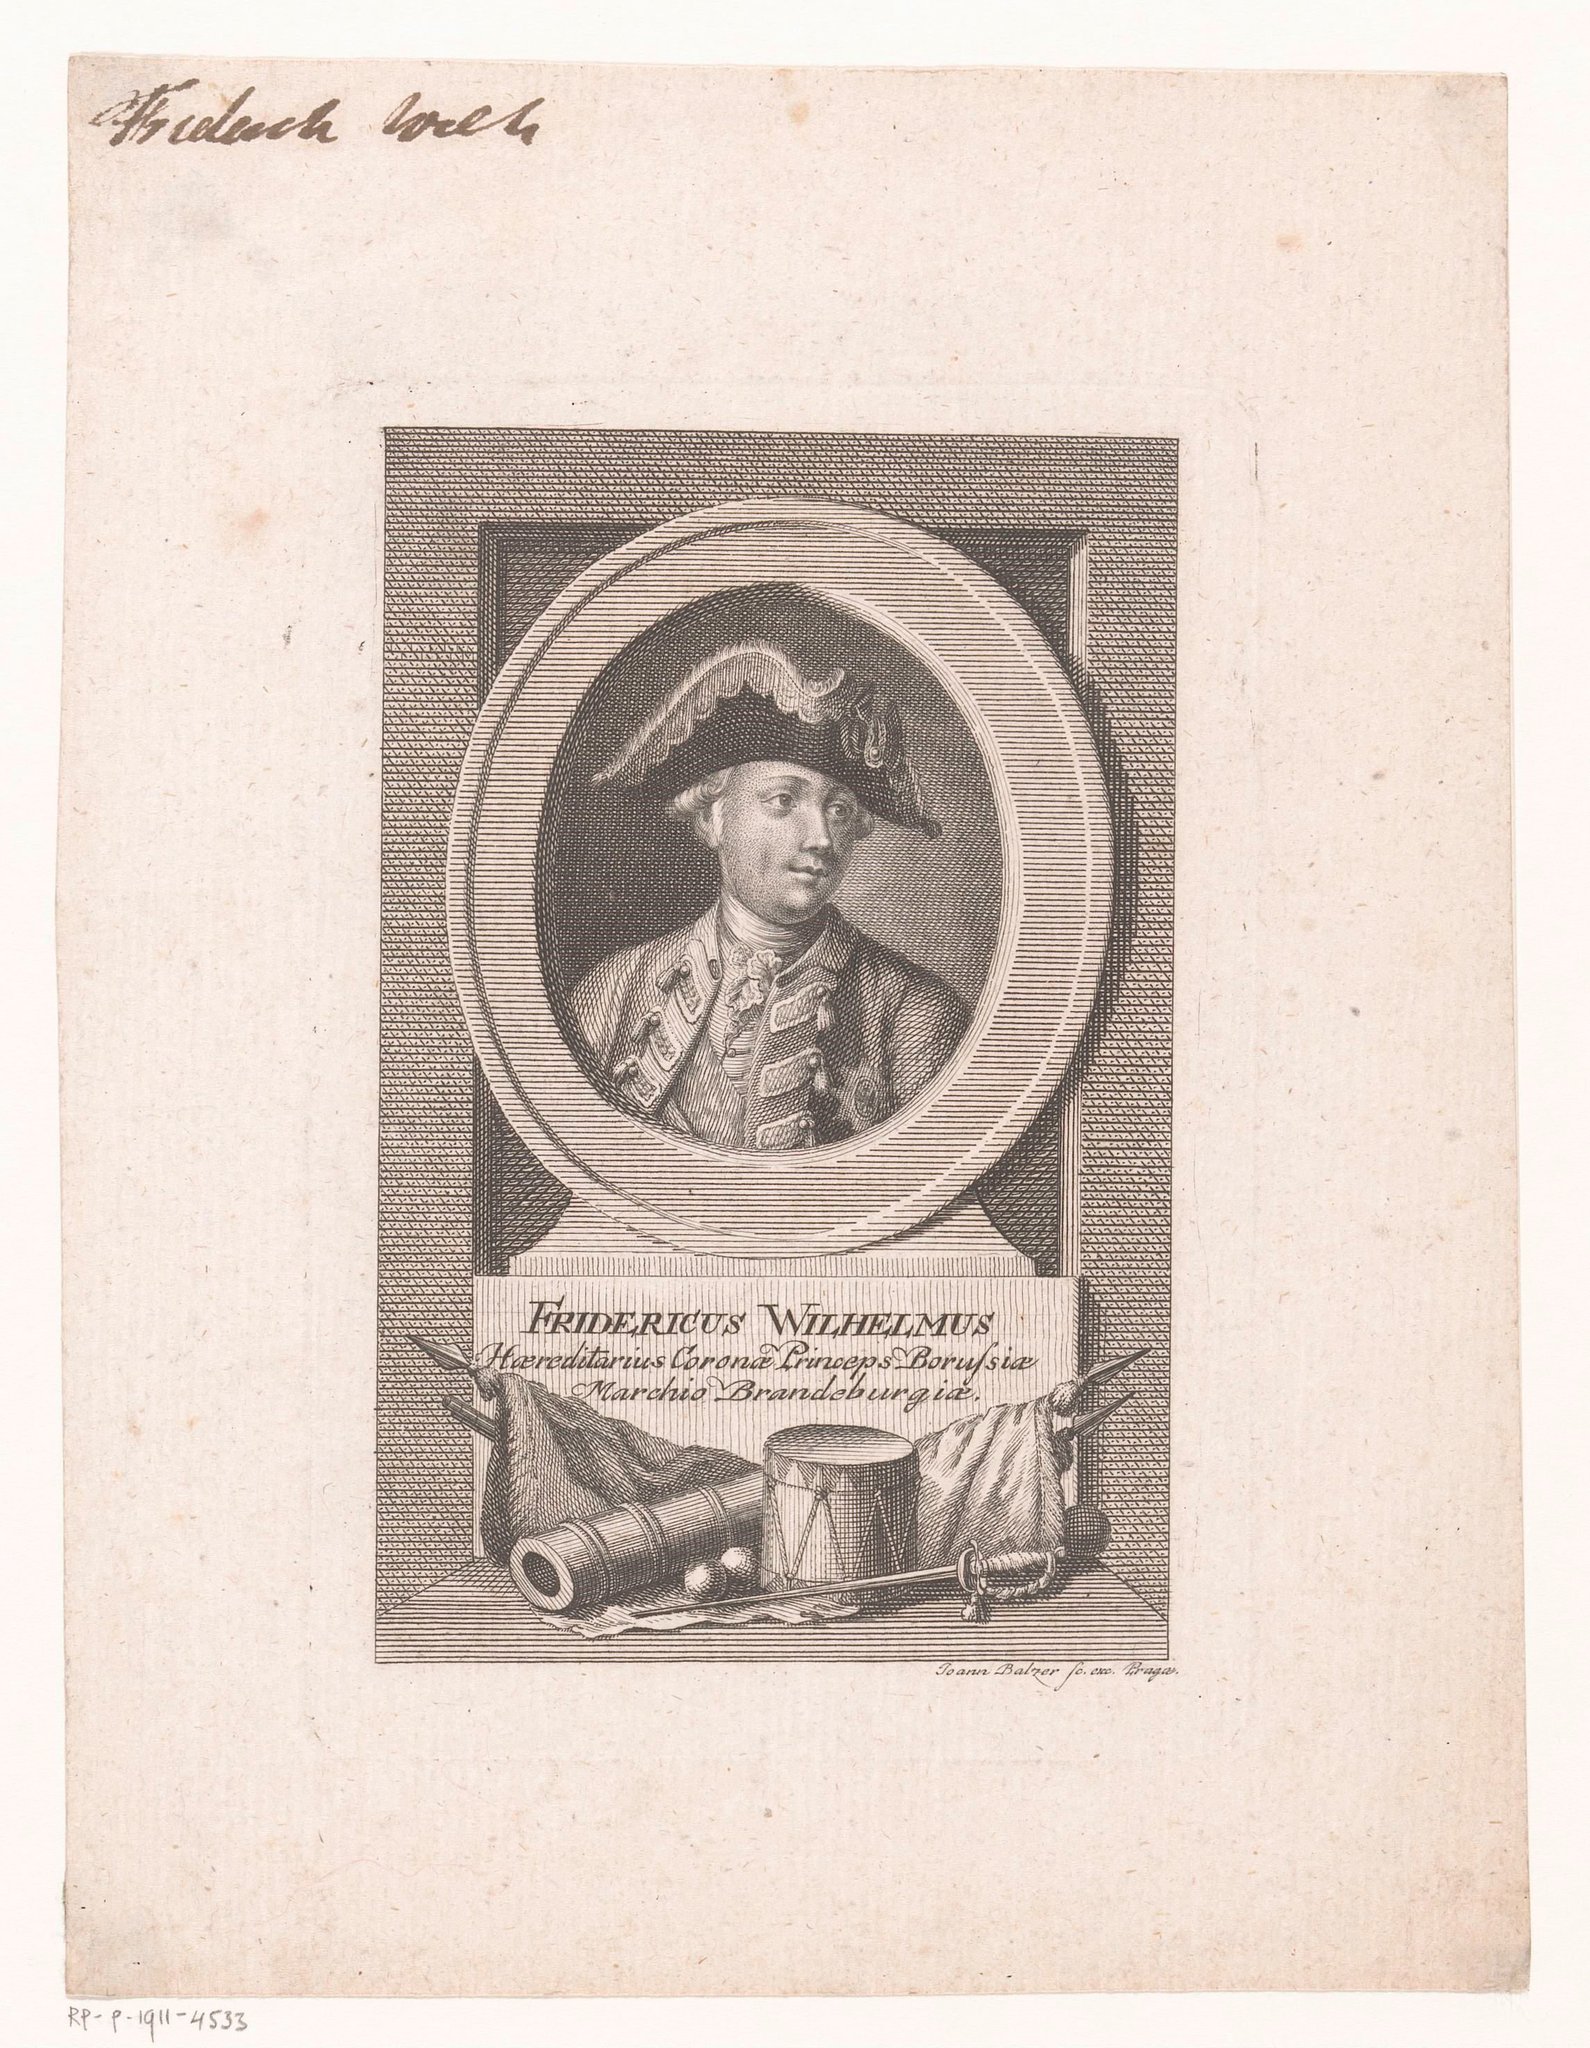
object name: print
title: Portret van Frederik Willem II van Pruissen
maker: jan balzer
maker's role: print maker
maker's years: 1736-1799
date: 1760-1786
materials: paper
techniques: engraving, etching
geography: prague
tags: berlin, frederik willem ii (koning van pruisen), historical persons, drum (musical instrument)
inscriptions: collector's mark: Lugt 2228